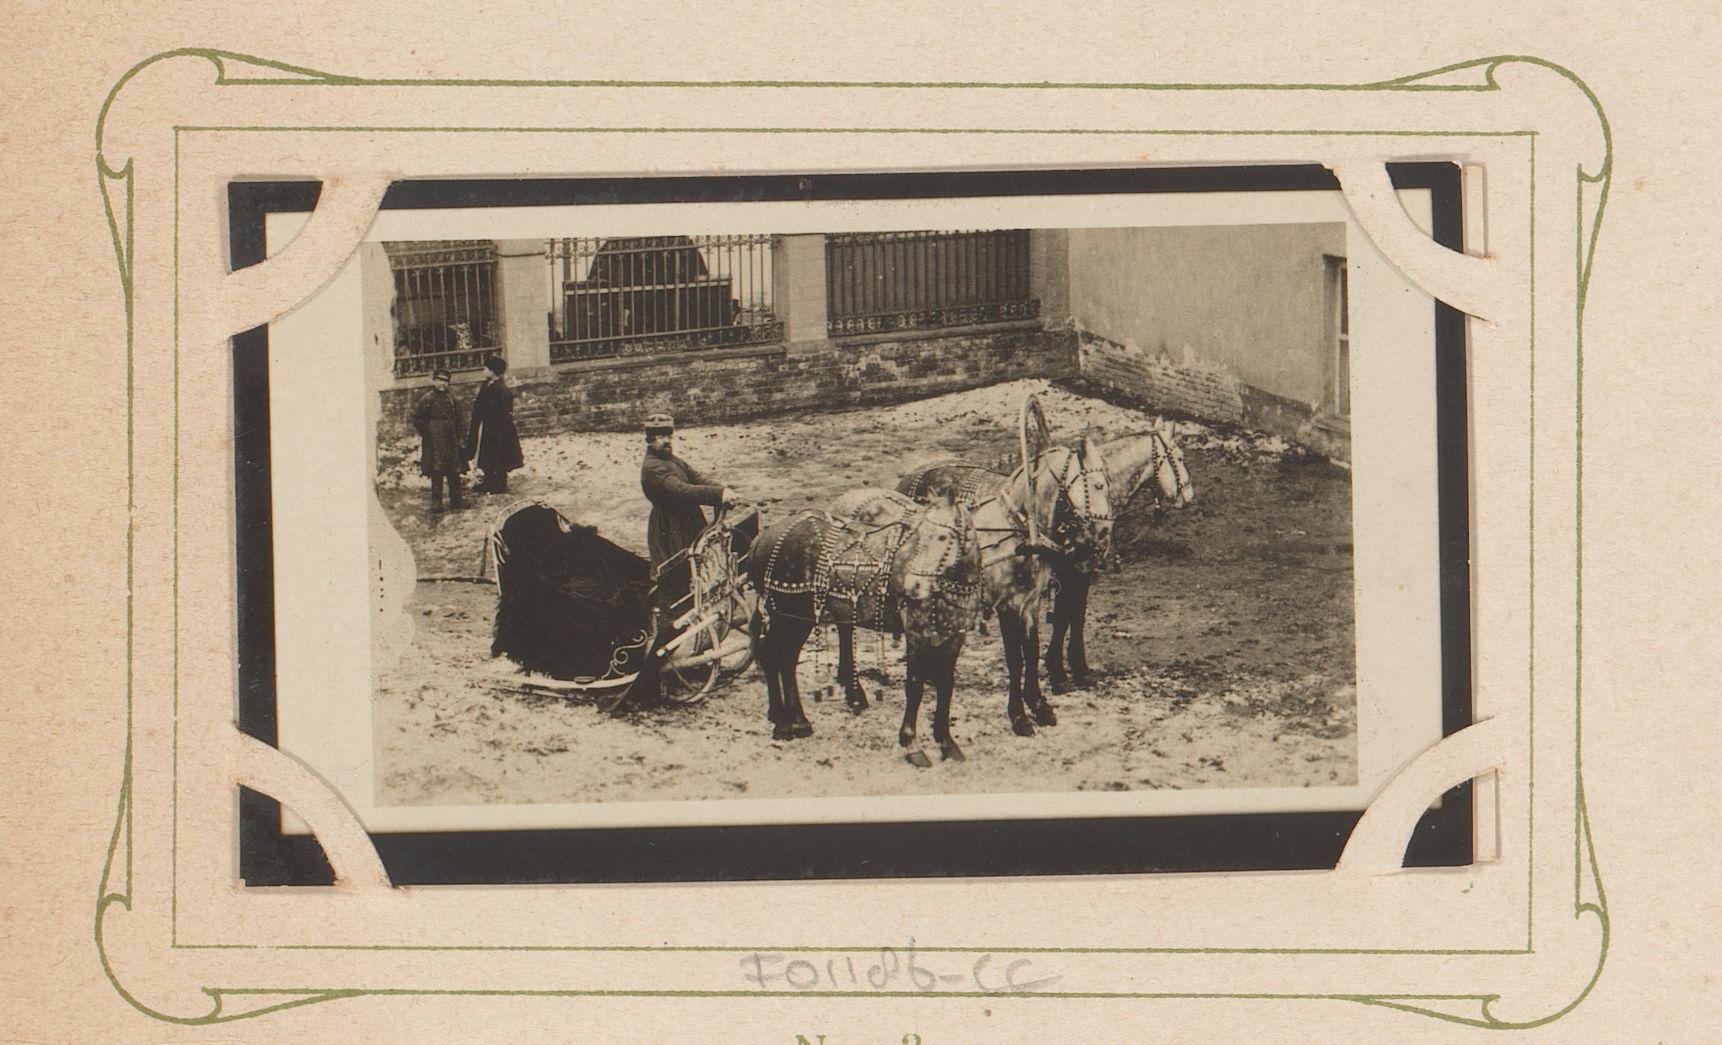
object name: album leaf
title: Troika voor een slee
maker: Anonymous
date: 1904-1905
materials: photographic support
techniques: gelatin silver print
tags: horse-sleigh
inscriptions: inscription: ‘No. 3./ Een heeren Troika voor de slede’